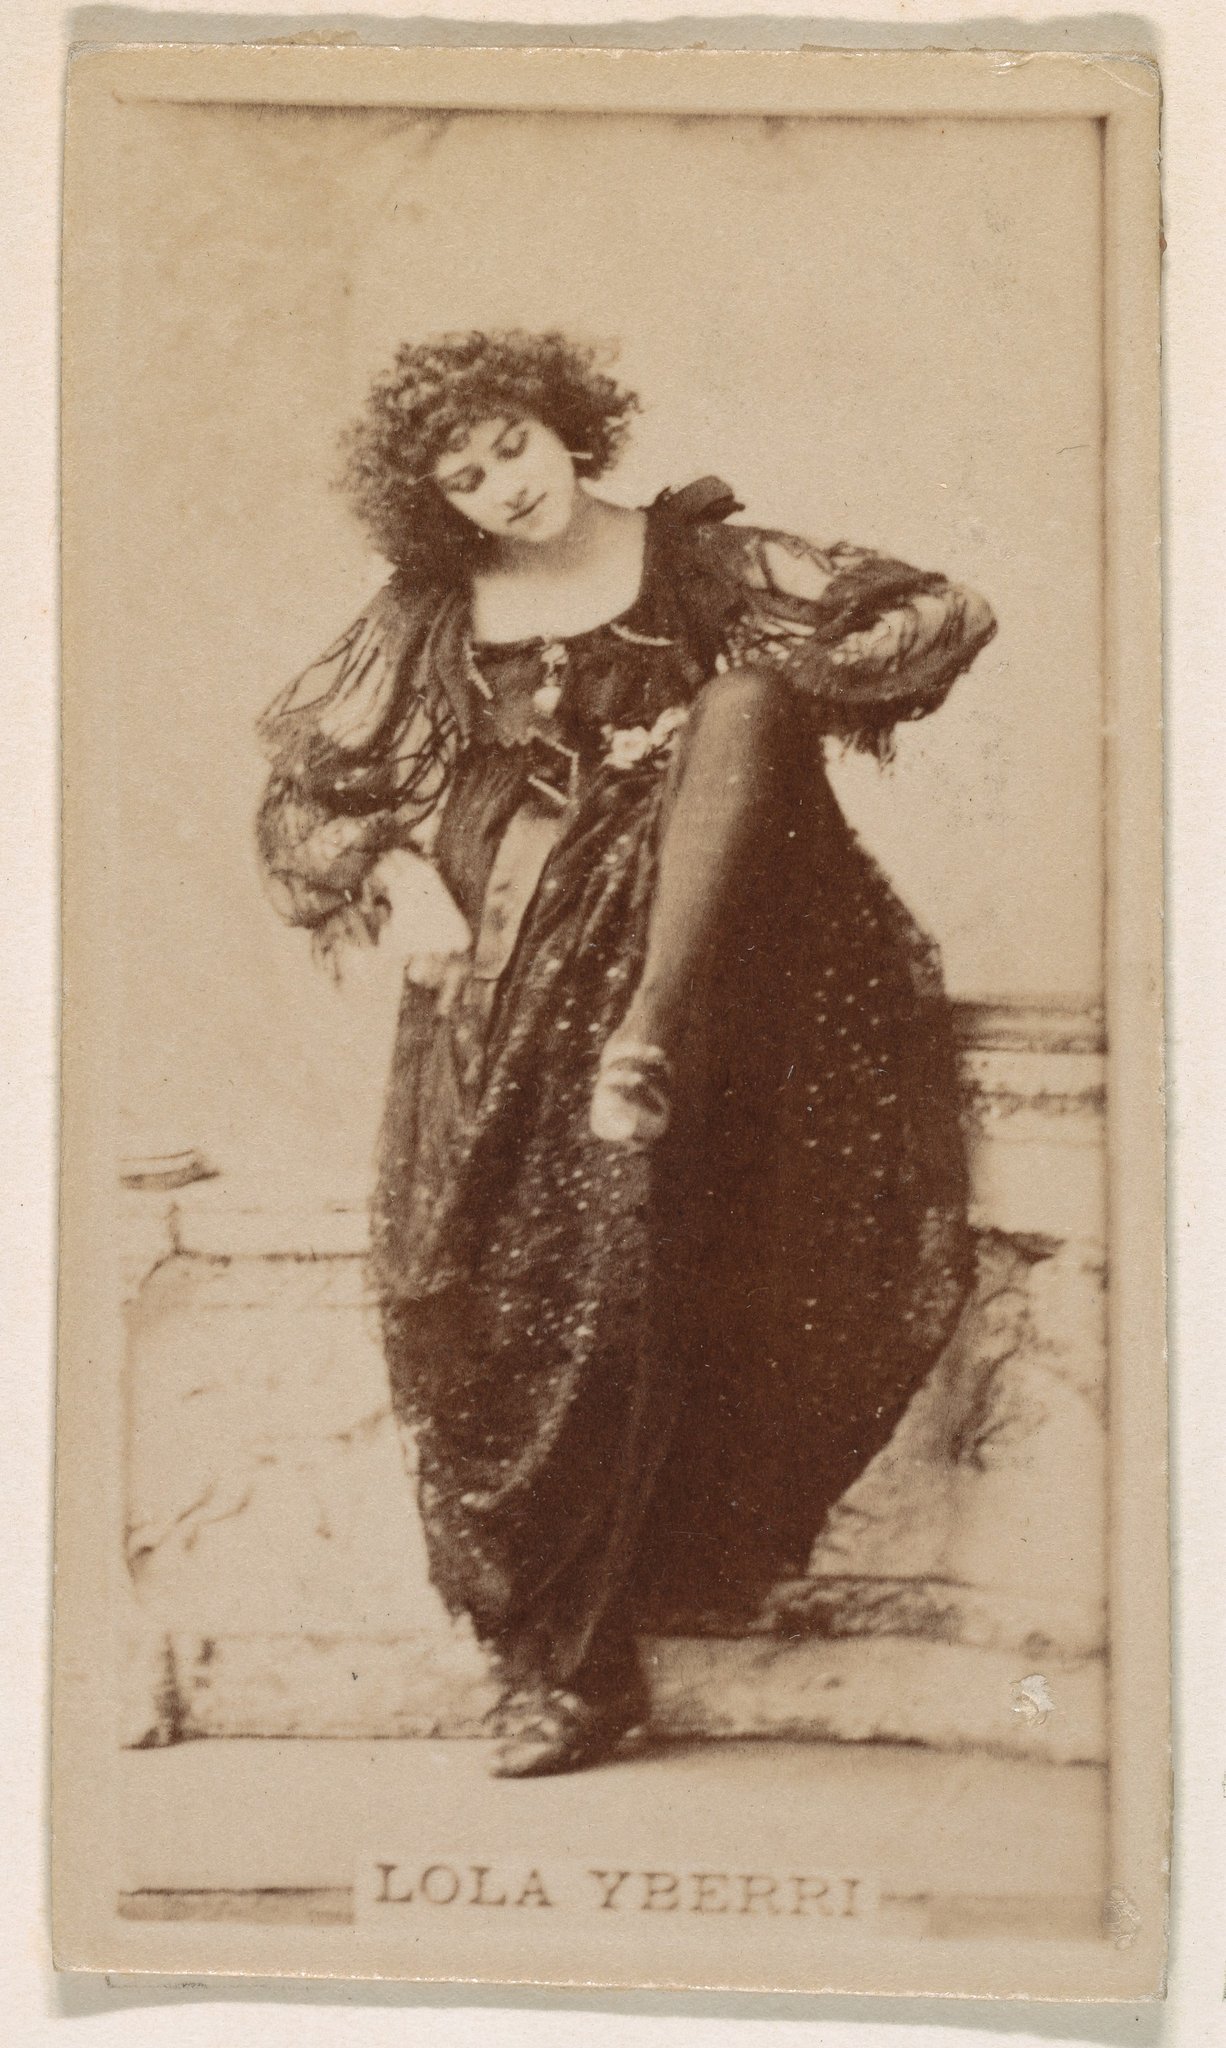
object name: photograph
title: Lola Yberri, from the Actresses series (N245) issued by Kinney Brothers to promote Sweet Caporal Cigarettes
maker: kinney brothers tobacco company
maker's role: publisher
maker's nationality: american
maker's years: 1869-2011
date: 1890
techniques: albumen silver print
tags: portraits,women,actresses